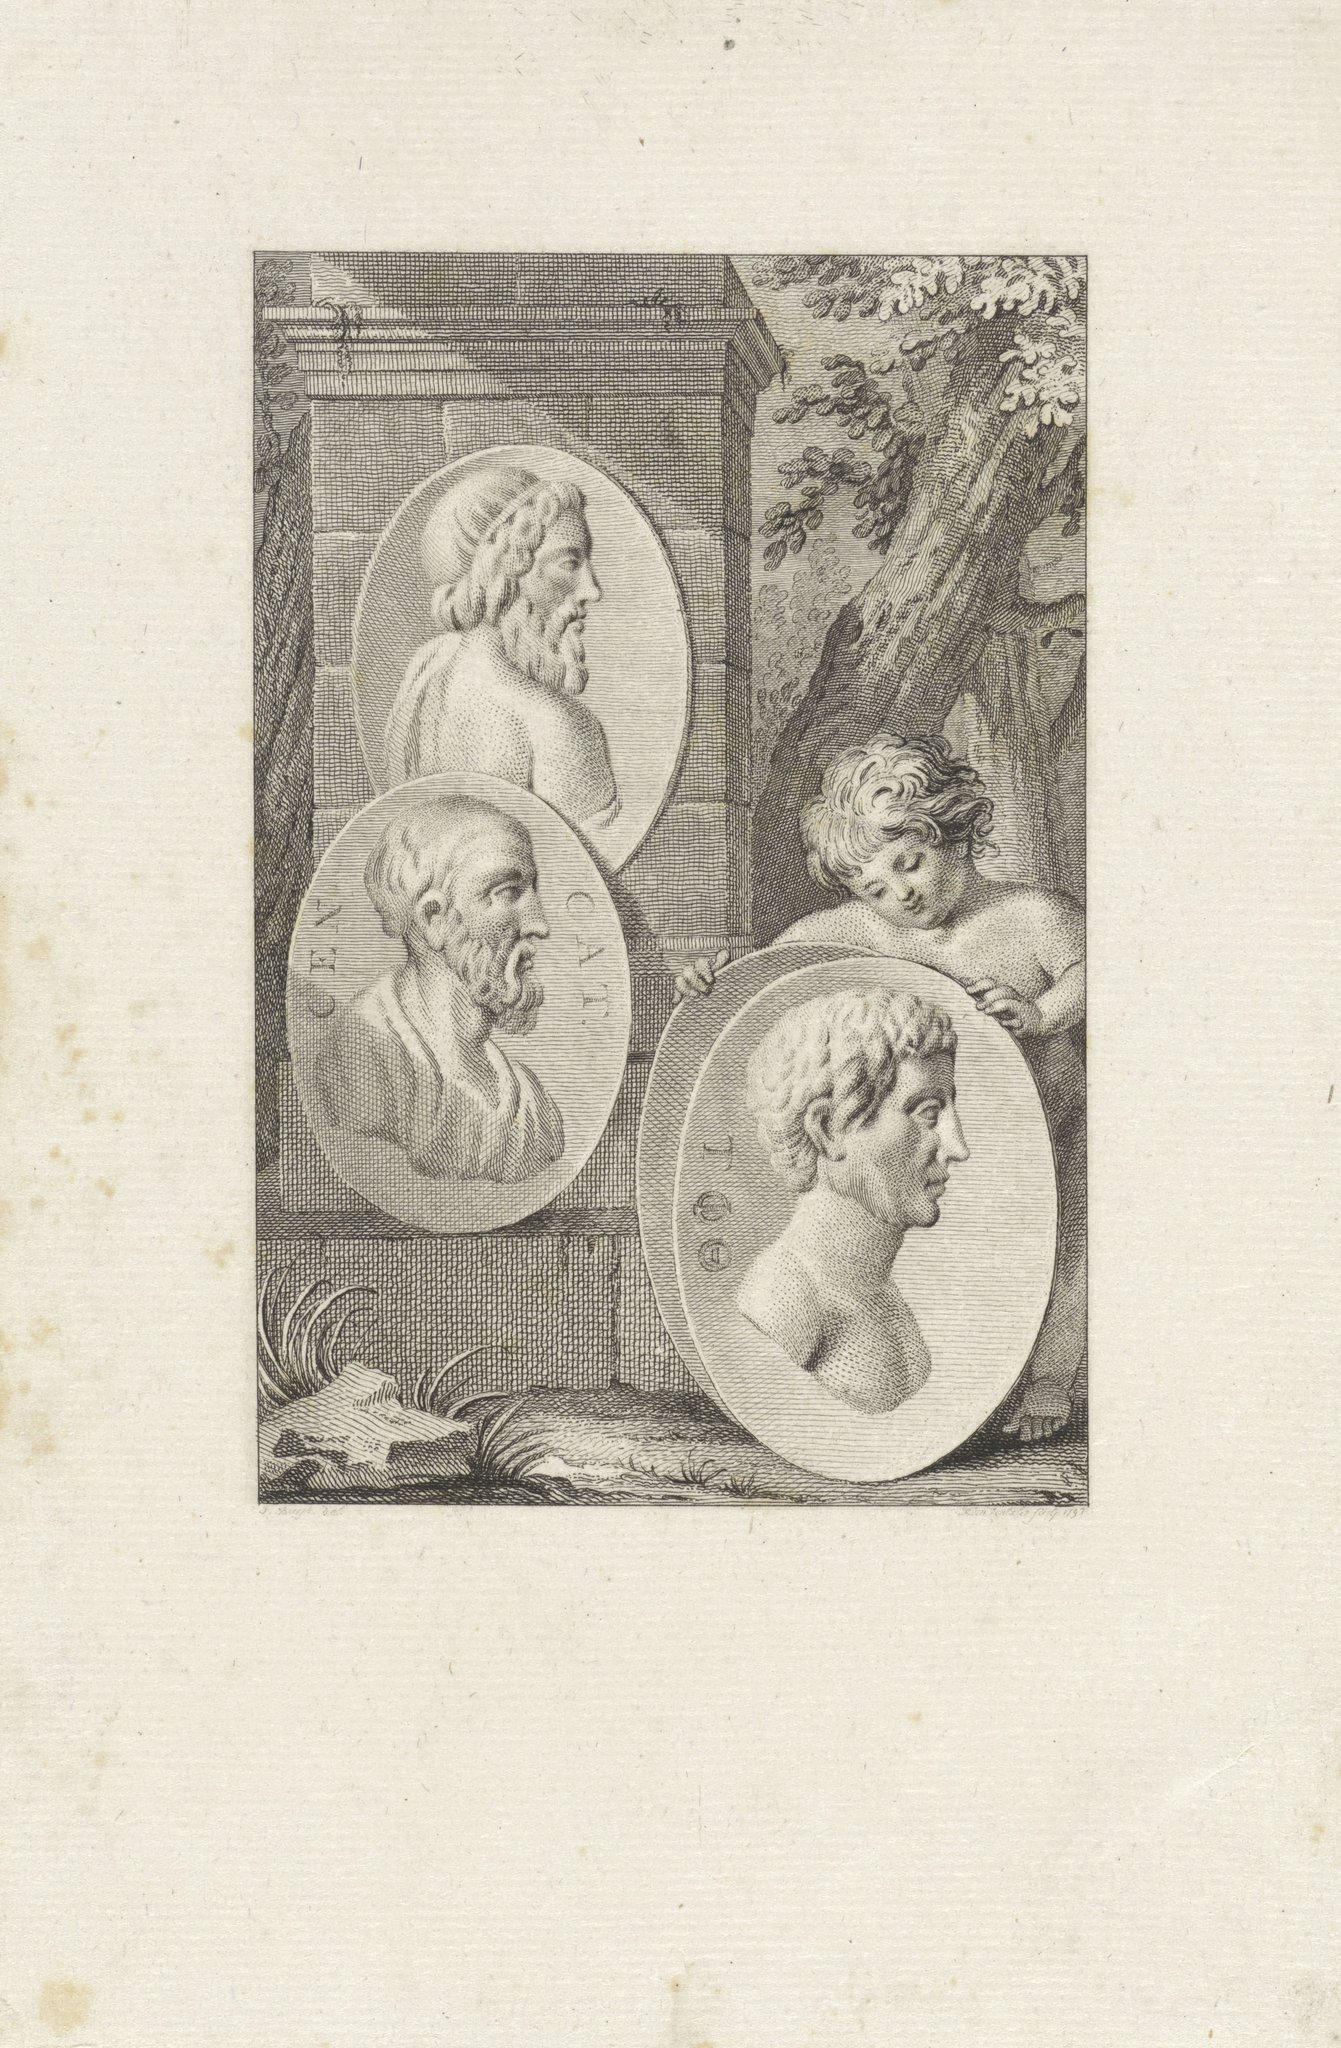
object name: print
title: Medaillons met portretten van Aristides, Cato de Oude en Flaminius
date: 1789-1809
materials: paper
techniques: etching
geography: amsterdam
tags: (story of) marcus porcius cato the elder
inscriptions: collector's mark: Lugt 240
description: Latere staat prent ook gebruikt als boekillustratie in: Plutarchus [bewerkt door E. Wassenbergh en H. Bosscha]. De levens van doorluchtige Grieken en Romeinen, onderling vergeleeken (...). 12 dln. Amsterdam: Johannes Allart, 1789-1809.